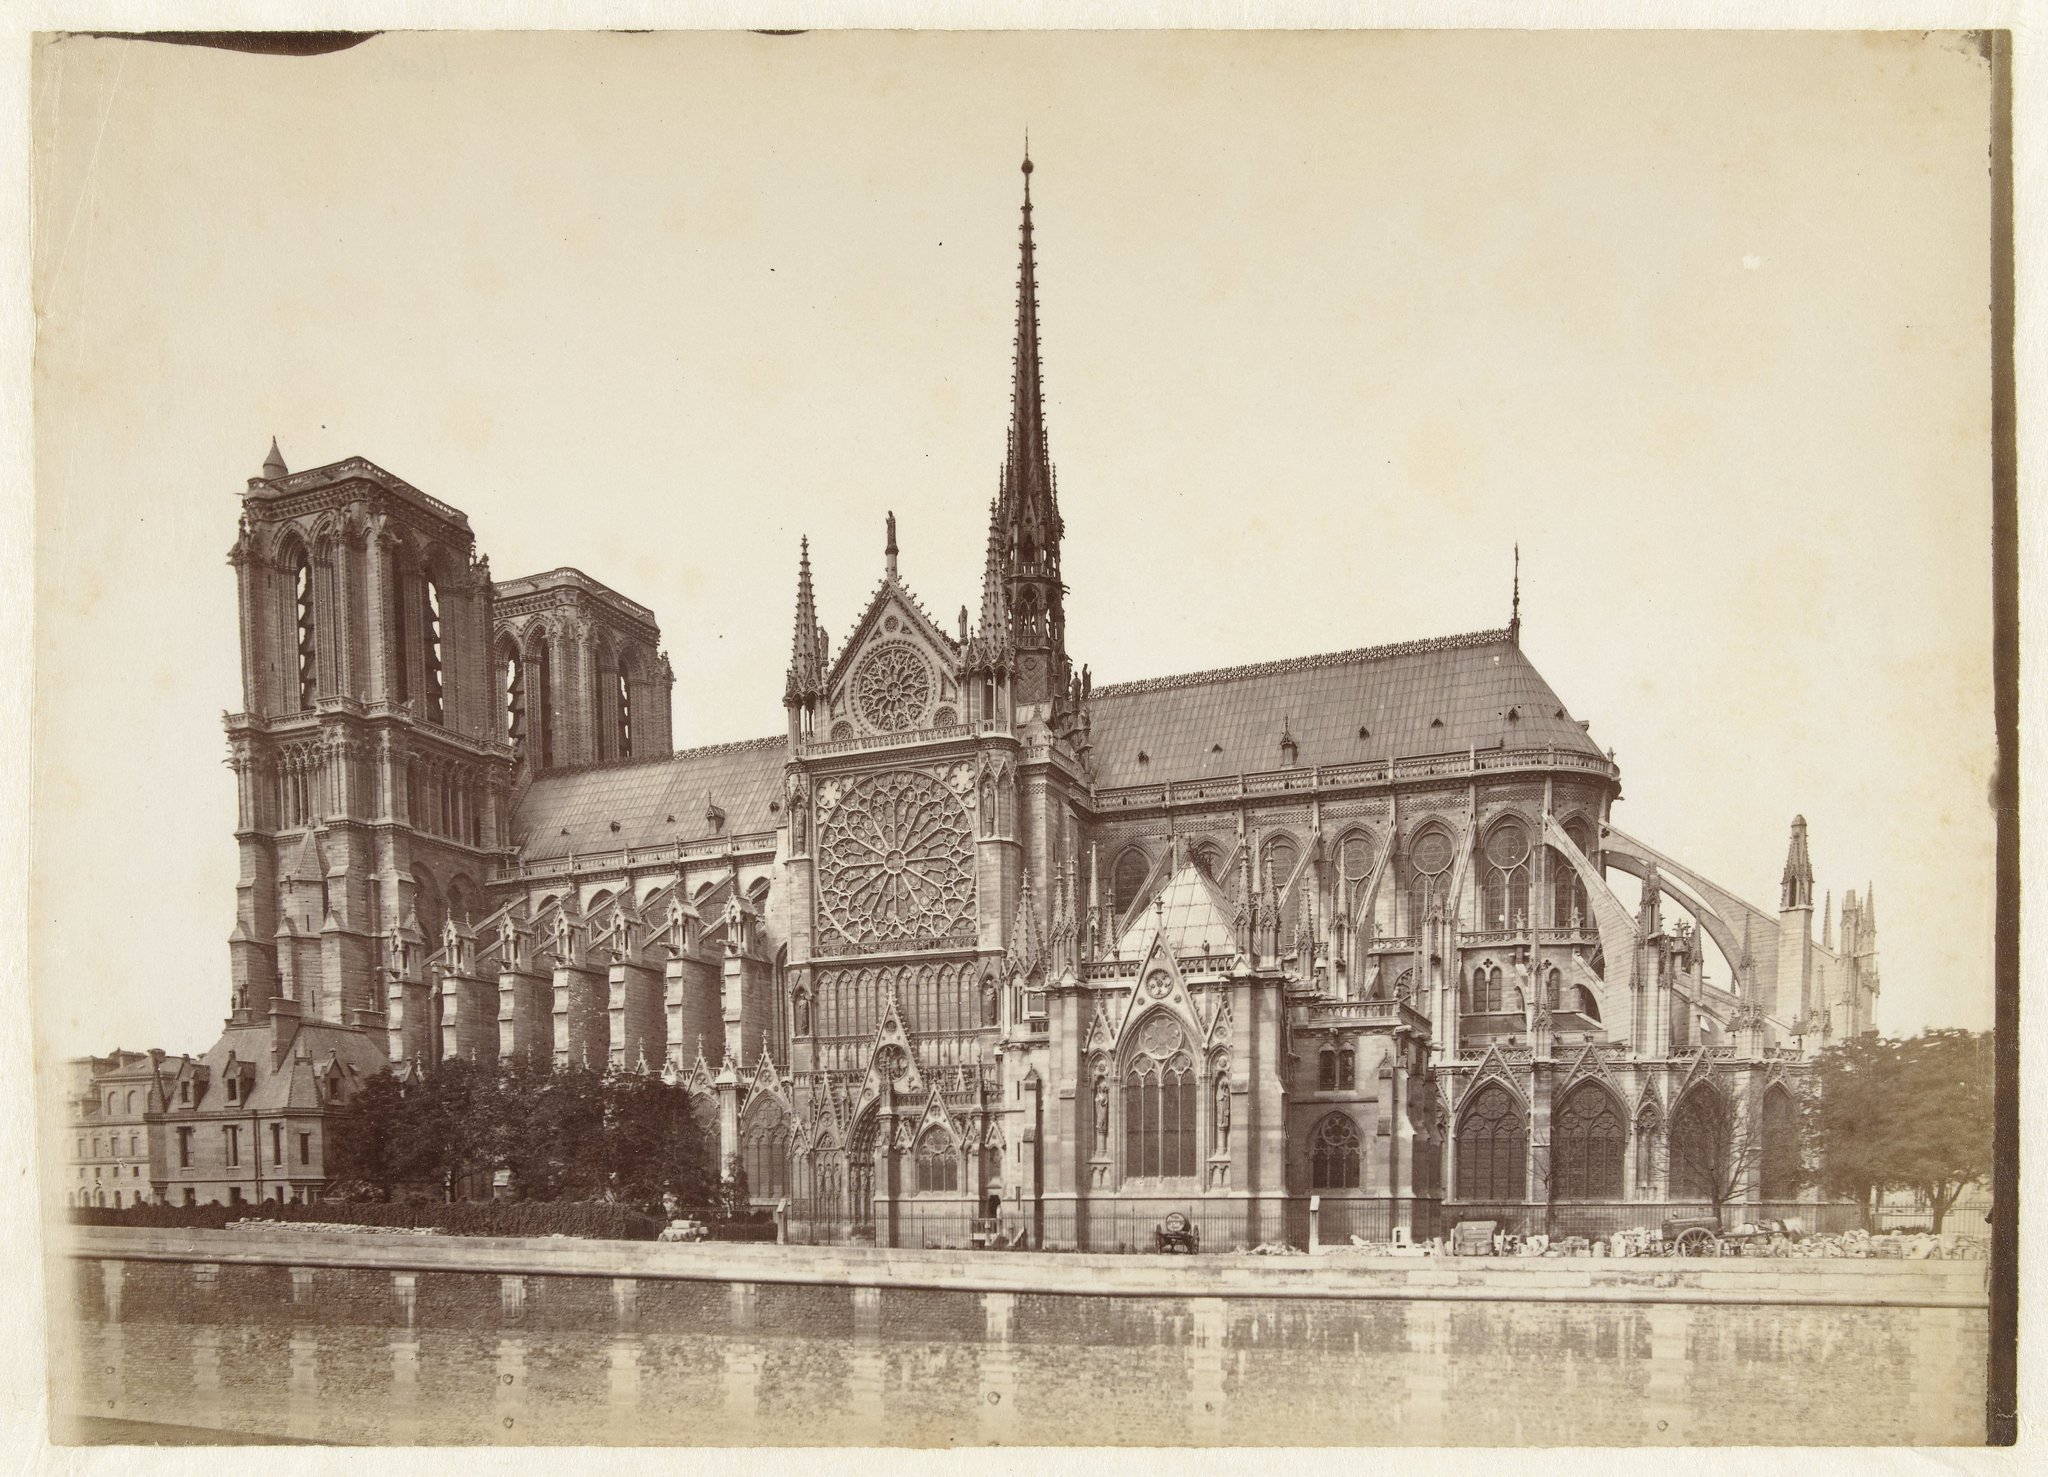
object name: photograph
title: Zijaanzicht van de Notre-Dame in Parijs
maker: Anonymous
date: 1860-1900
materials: paper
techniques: albumen print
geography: paris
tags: church (exterior)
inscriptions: number: ‘454’